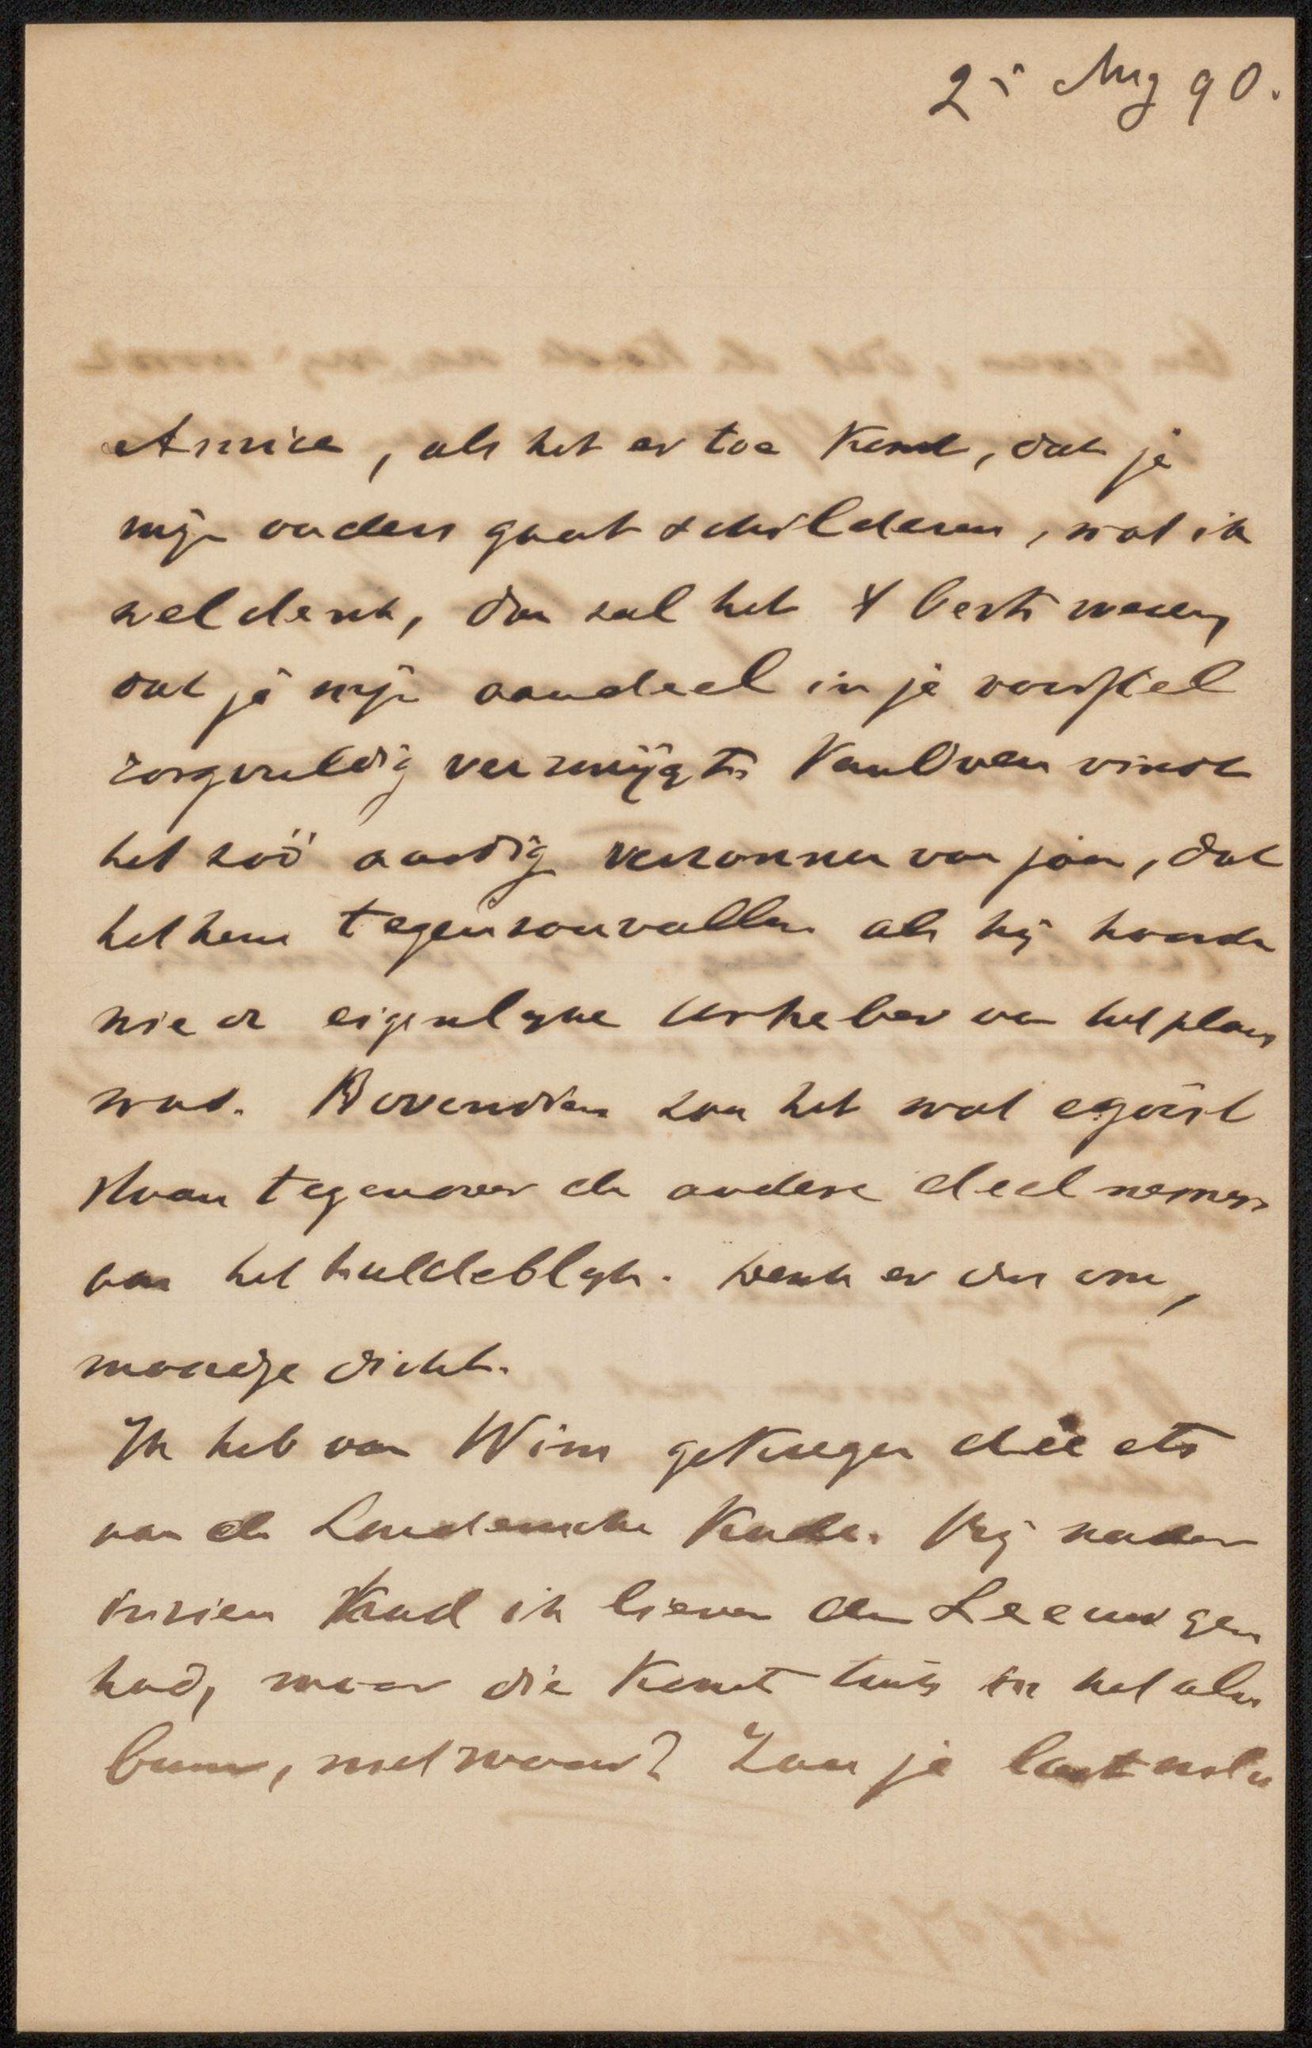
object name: letter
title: Brief aan Jan Veth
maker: chap van deventer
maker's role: kunstcriticus, scheikundige, schrijver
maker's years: 1860-1931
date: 1890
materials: ink, paper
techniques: pen, printing, writing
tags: painter, print maker, draughtsman, designer, jan veth, willem witsen, artist's model, sitter, the graphic arts, painting (including book-illumination, miniature-painting), historical persons (portraits and scenes from the life)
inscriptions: collector's mark: ‘RPK’